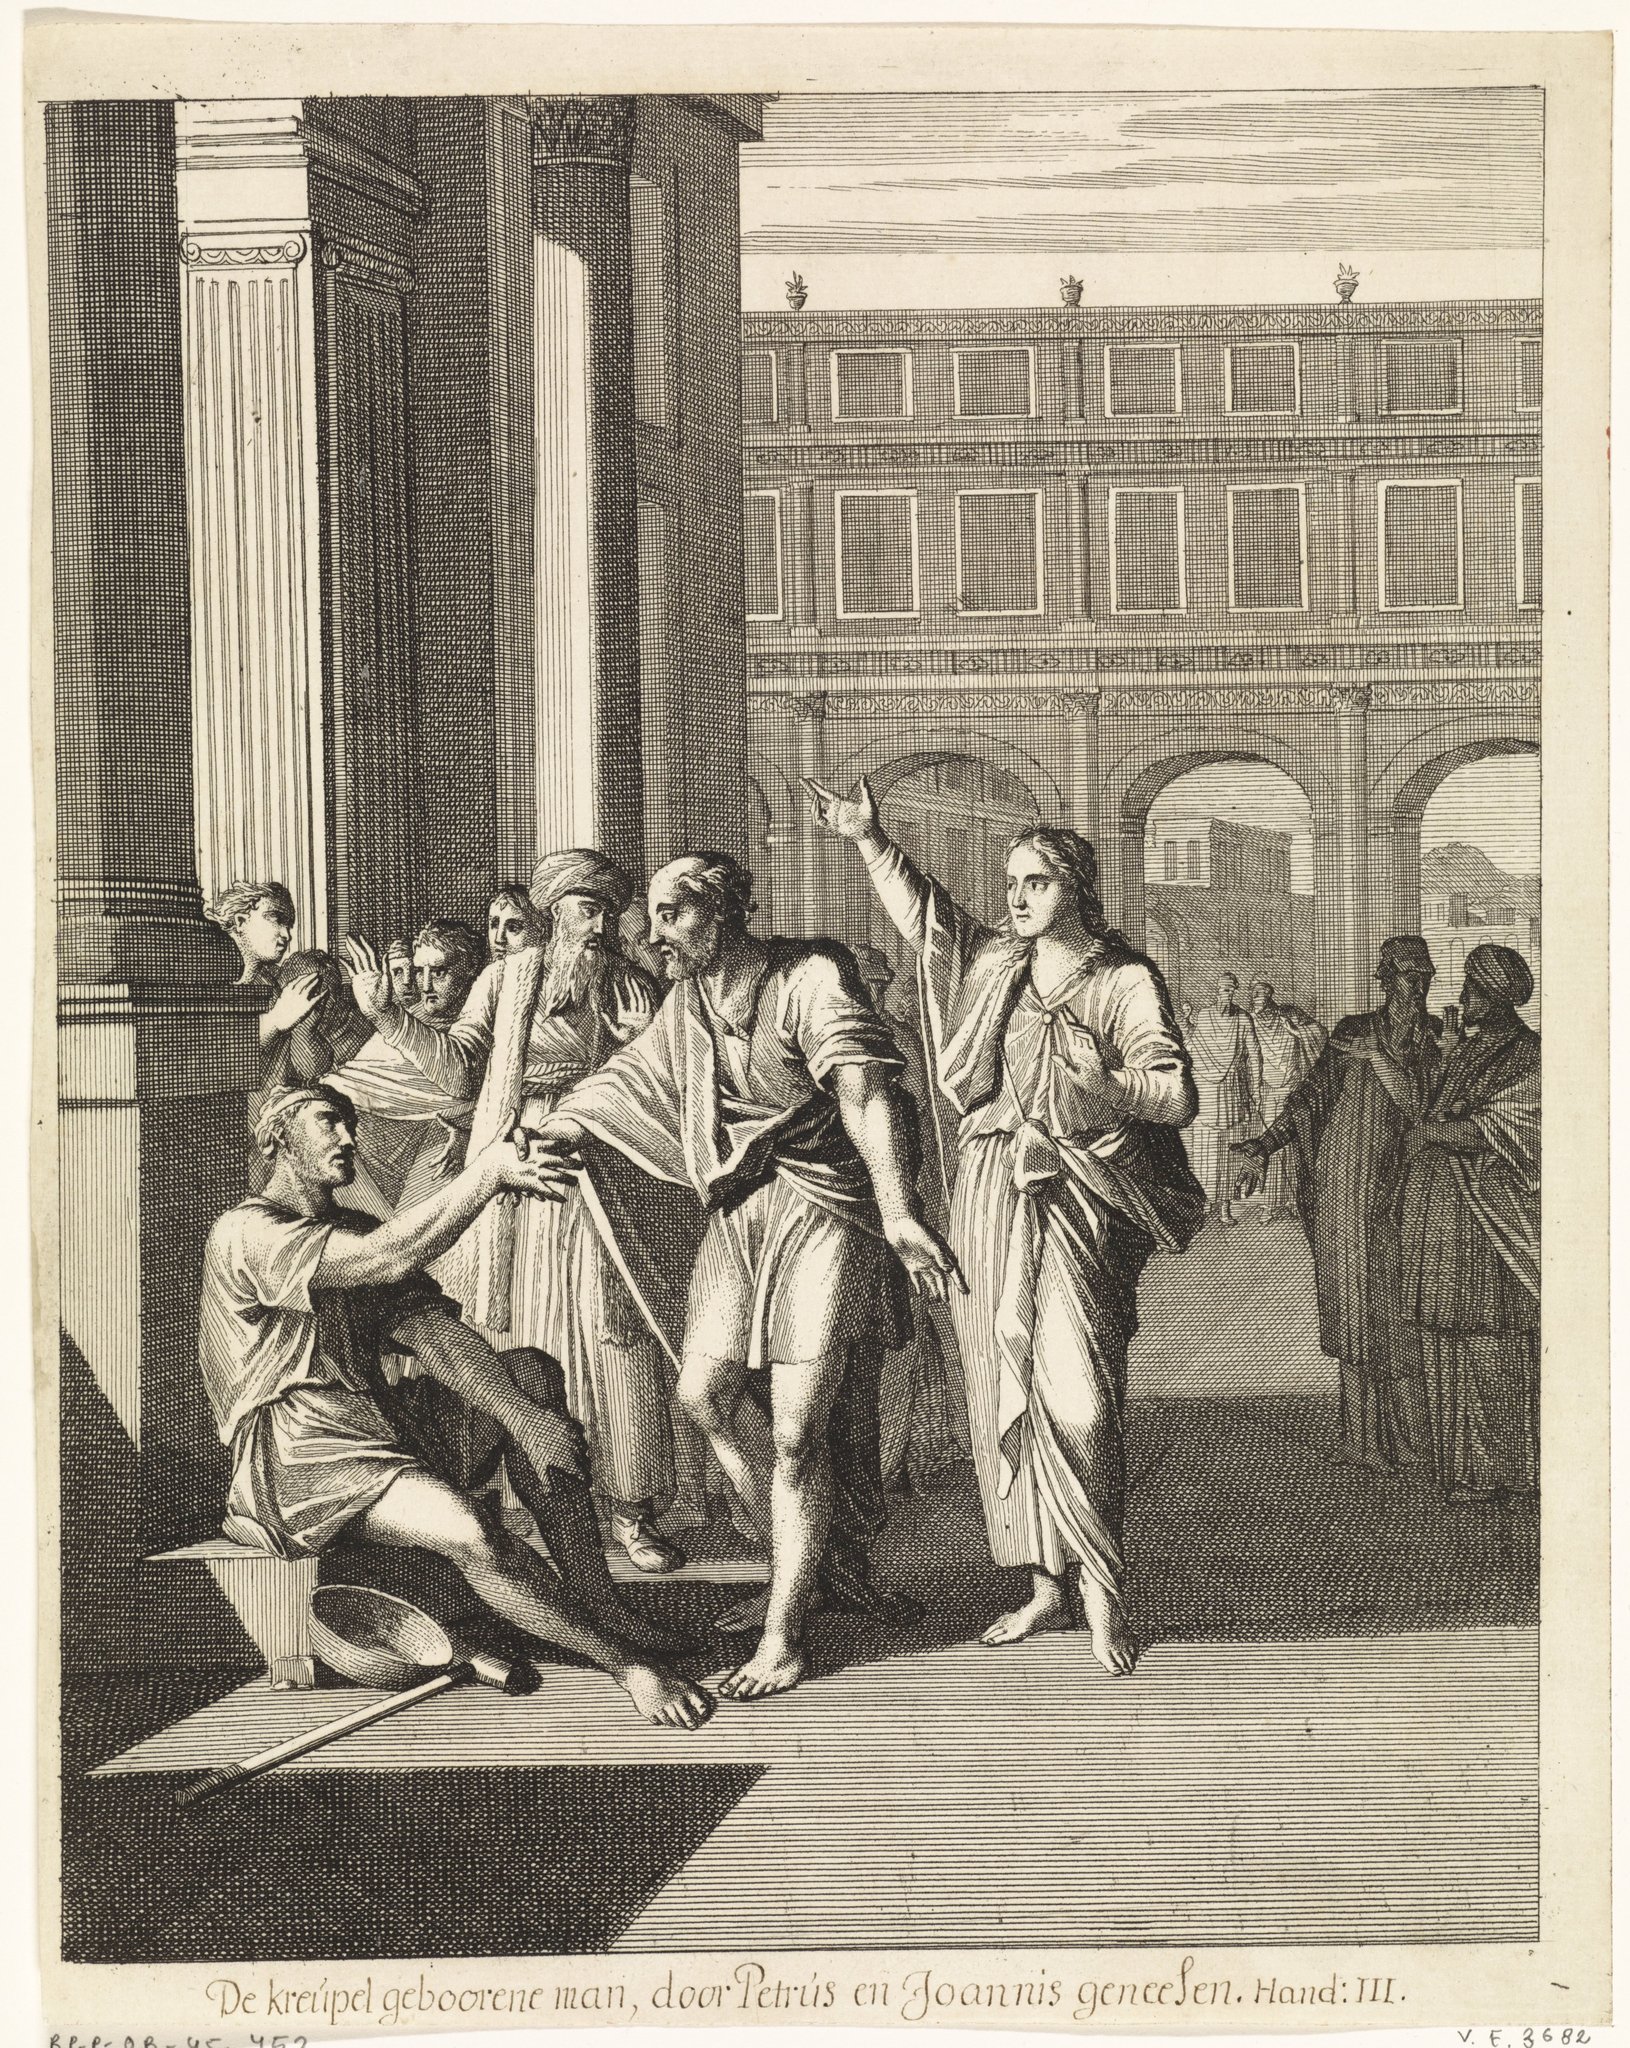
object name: print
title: Petrus en Johannes genezen een kreupele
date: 1708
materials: paper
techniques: etching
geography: nuremberg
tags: healing of a lame beggar at the beautiful gate of the temple by peter and john (acts 3 - 4:31), disabilities, deformations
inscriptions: collector's mark: Lugt 2228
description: Proefdruk van een prent welke is opgenomen als illustratie in: Historiae Celebriores Veteris Testamenti. Christoph Weigel, 1708.